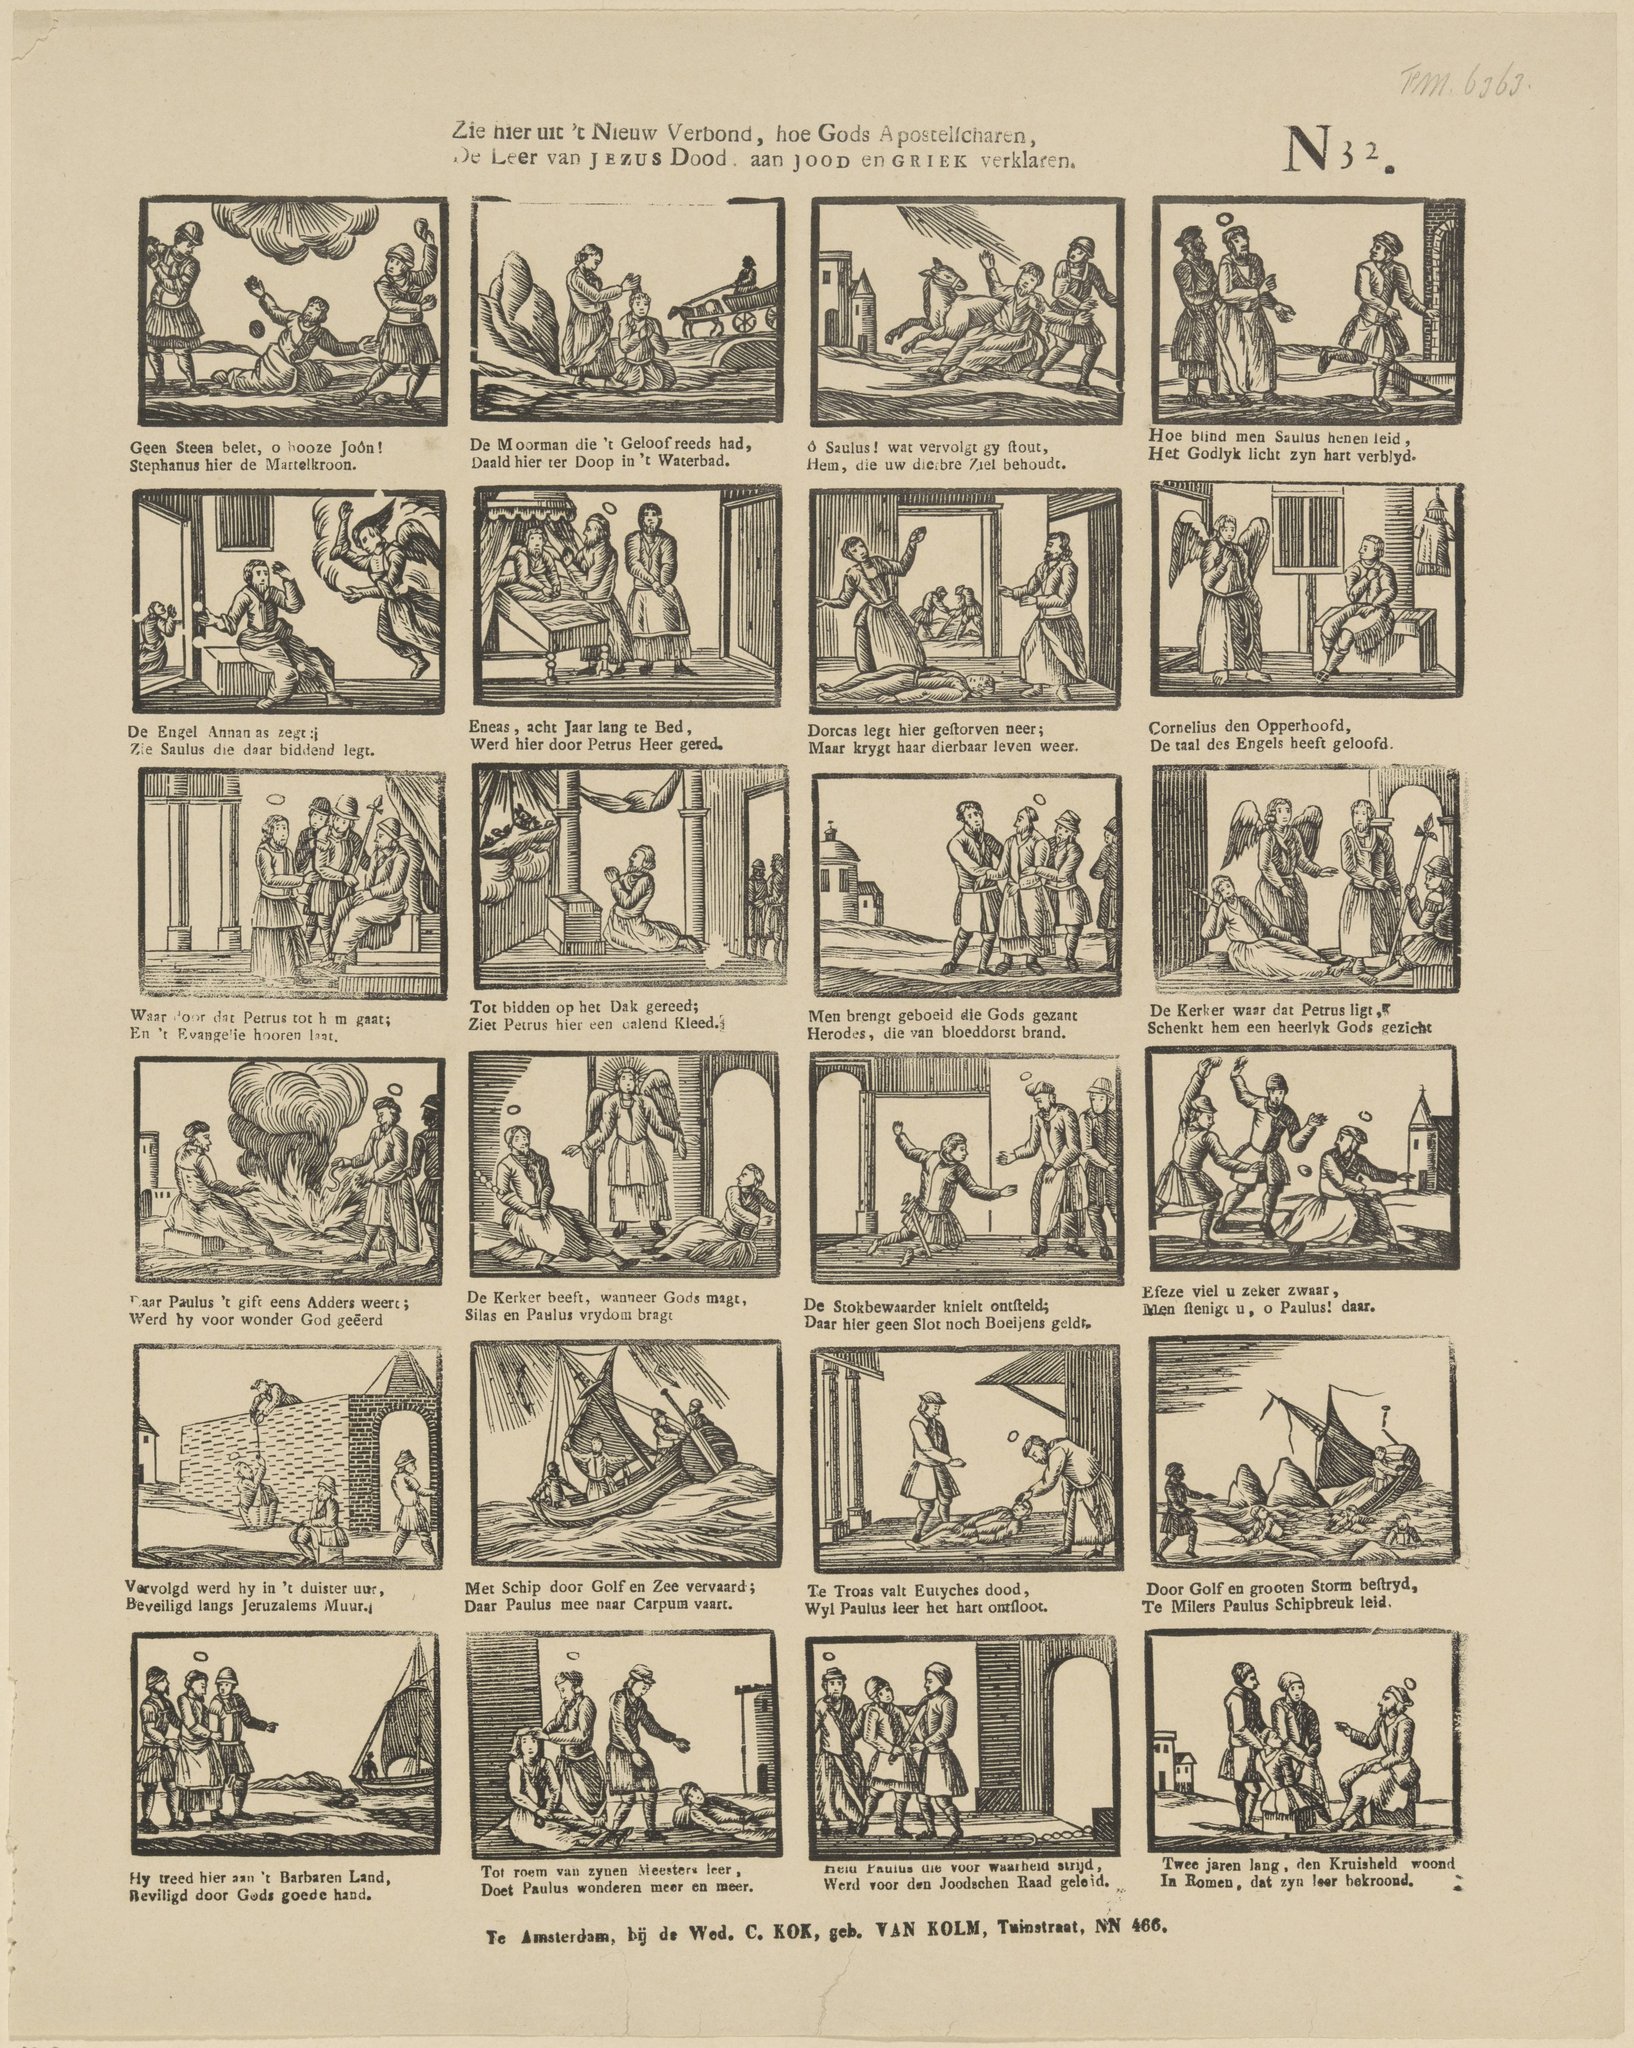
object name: popular print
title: Zie hier uit 't nieuwe verbond, hoe Gods apostelscharen, / De leer van Jezus dood aan Jood en Griek verklaren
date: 1842-1866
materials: paper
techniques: letterpress printing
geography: netherlands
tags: mission of the apostles, lives and acts of the apostles (part ii), lives and acts of the apostles (part i)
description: Blad met 24 voorstellingen van de apostelen die het geloof verkondigen. Onder elke afbeelding een tweeregelig vers. Genummerd rechtsboven: No. 32.